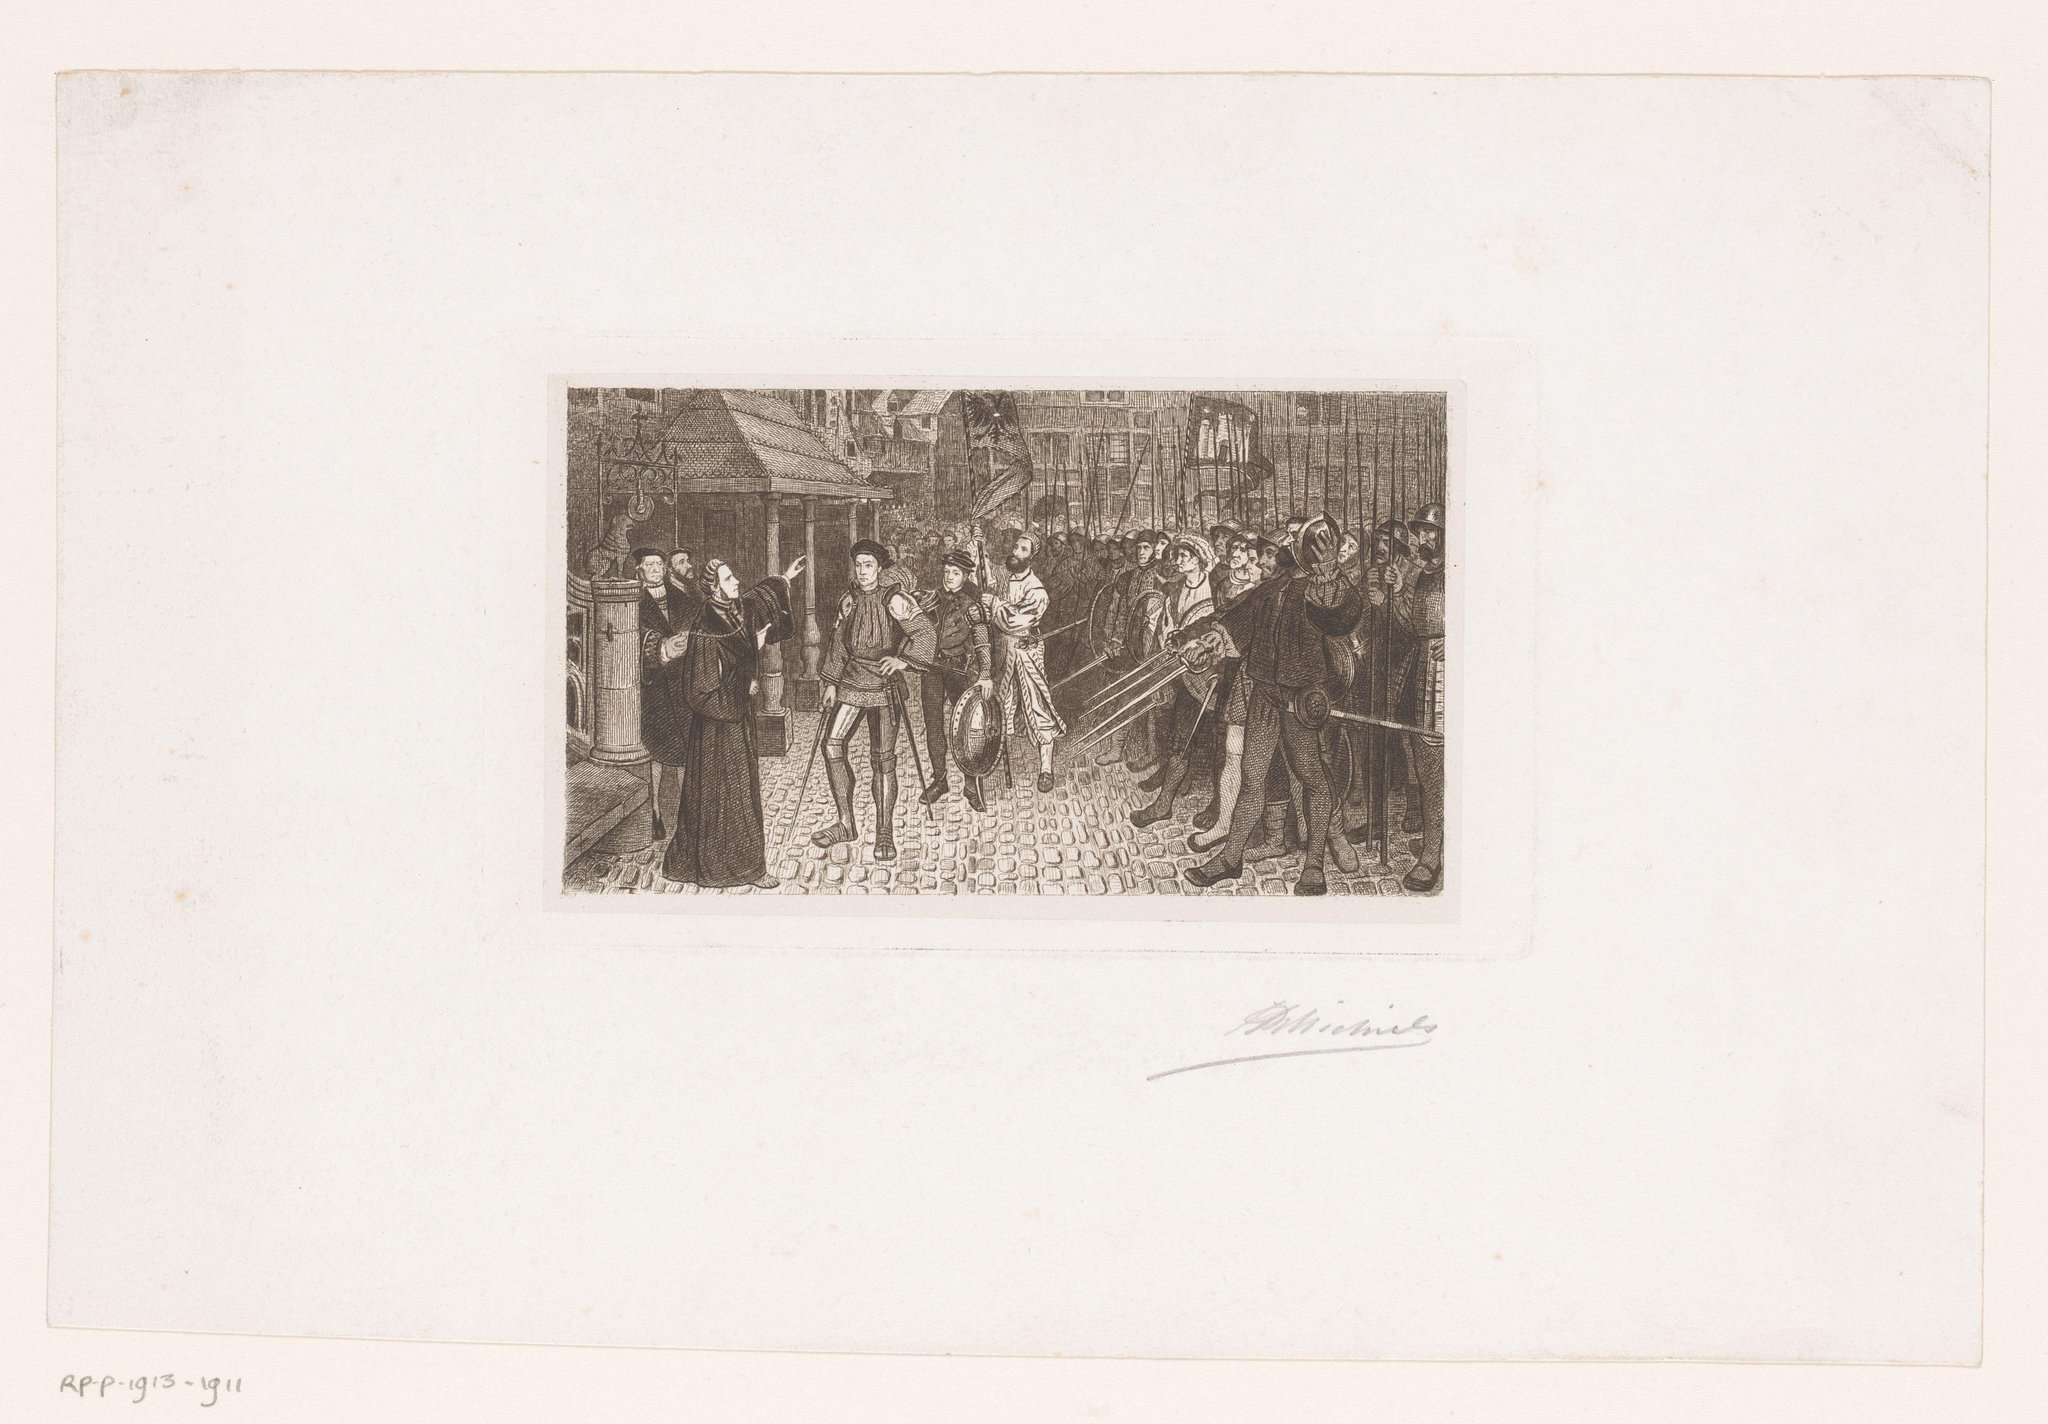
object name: print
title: Burgemeester Lancelot van Ursel geeft schepen Cornelis van Spangen het bevel over de burgerwacht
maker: jean baptiste pierre michiels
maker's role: print maker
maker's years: 1821-1890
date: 1863-1890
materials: paper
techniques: etching, intaglio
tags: mayor, burgomaster, taking the oath ~ military service, meeting of soldiers and/or officers, antwerp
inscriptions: collector's mark: Lugt 2228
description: De burgerwacht werd in 1542 ingezet ter verdediging van de stad Antwerpen tegen Maarten van Rossum. De prent is gemaakt naar de muurschilderingen van Henri Leys in het Stadhuis van Antwerpen.